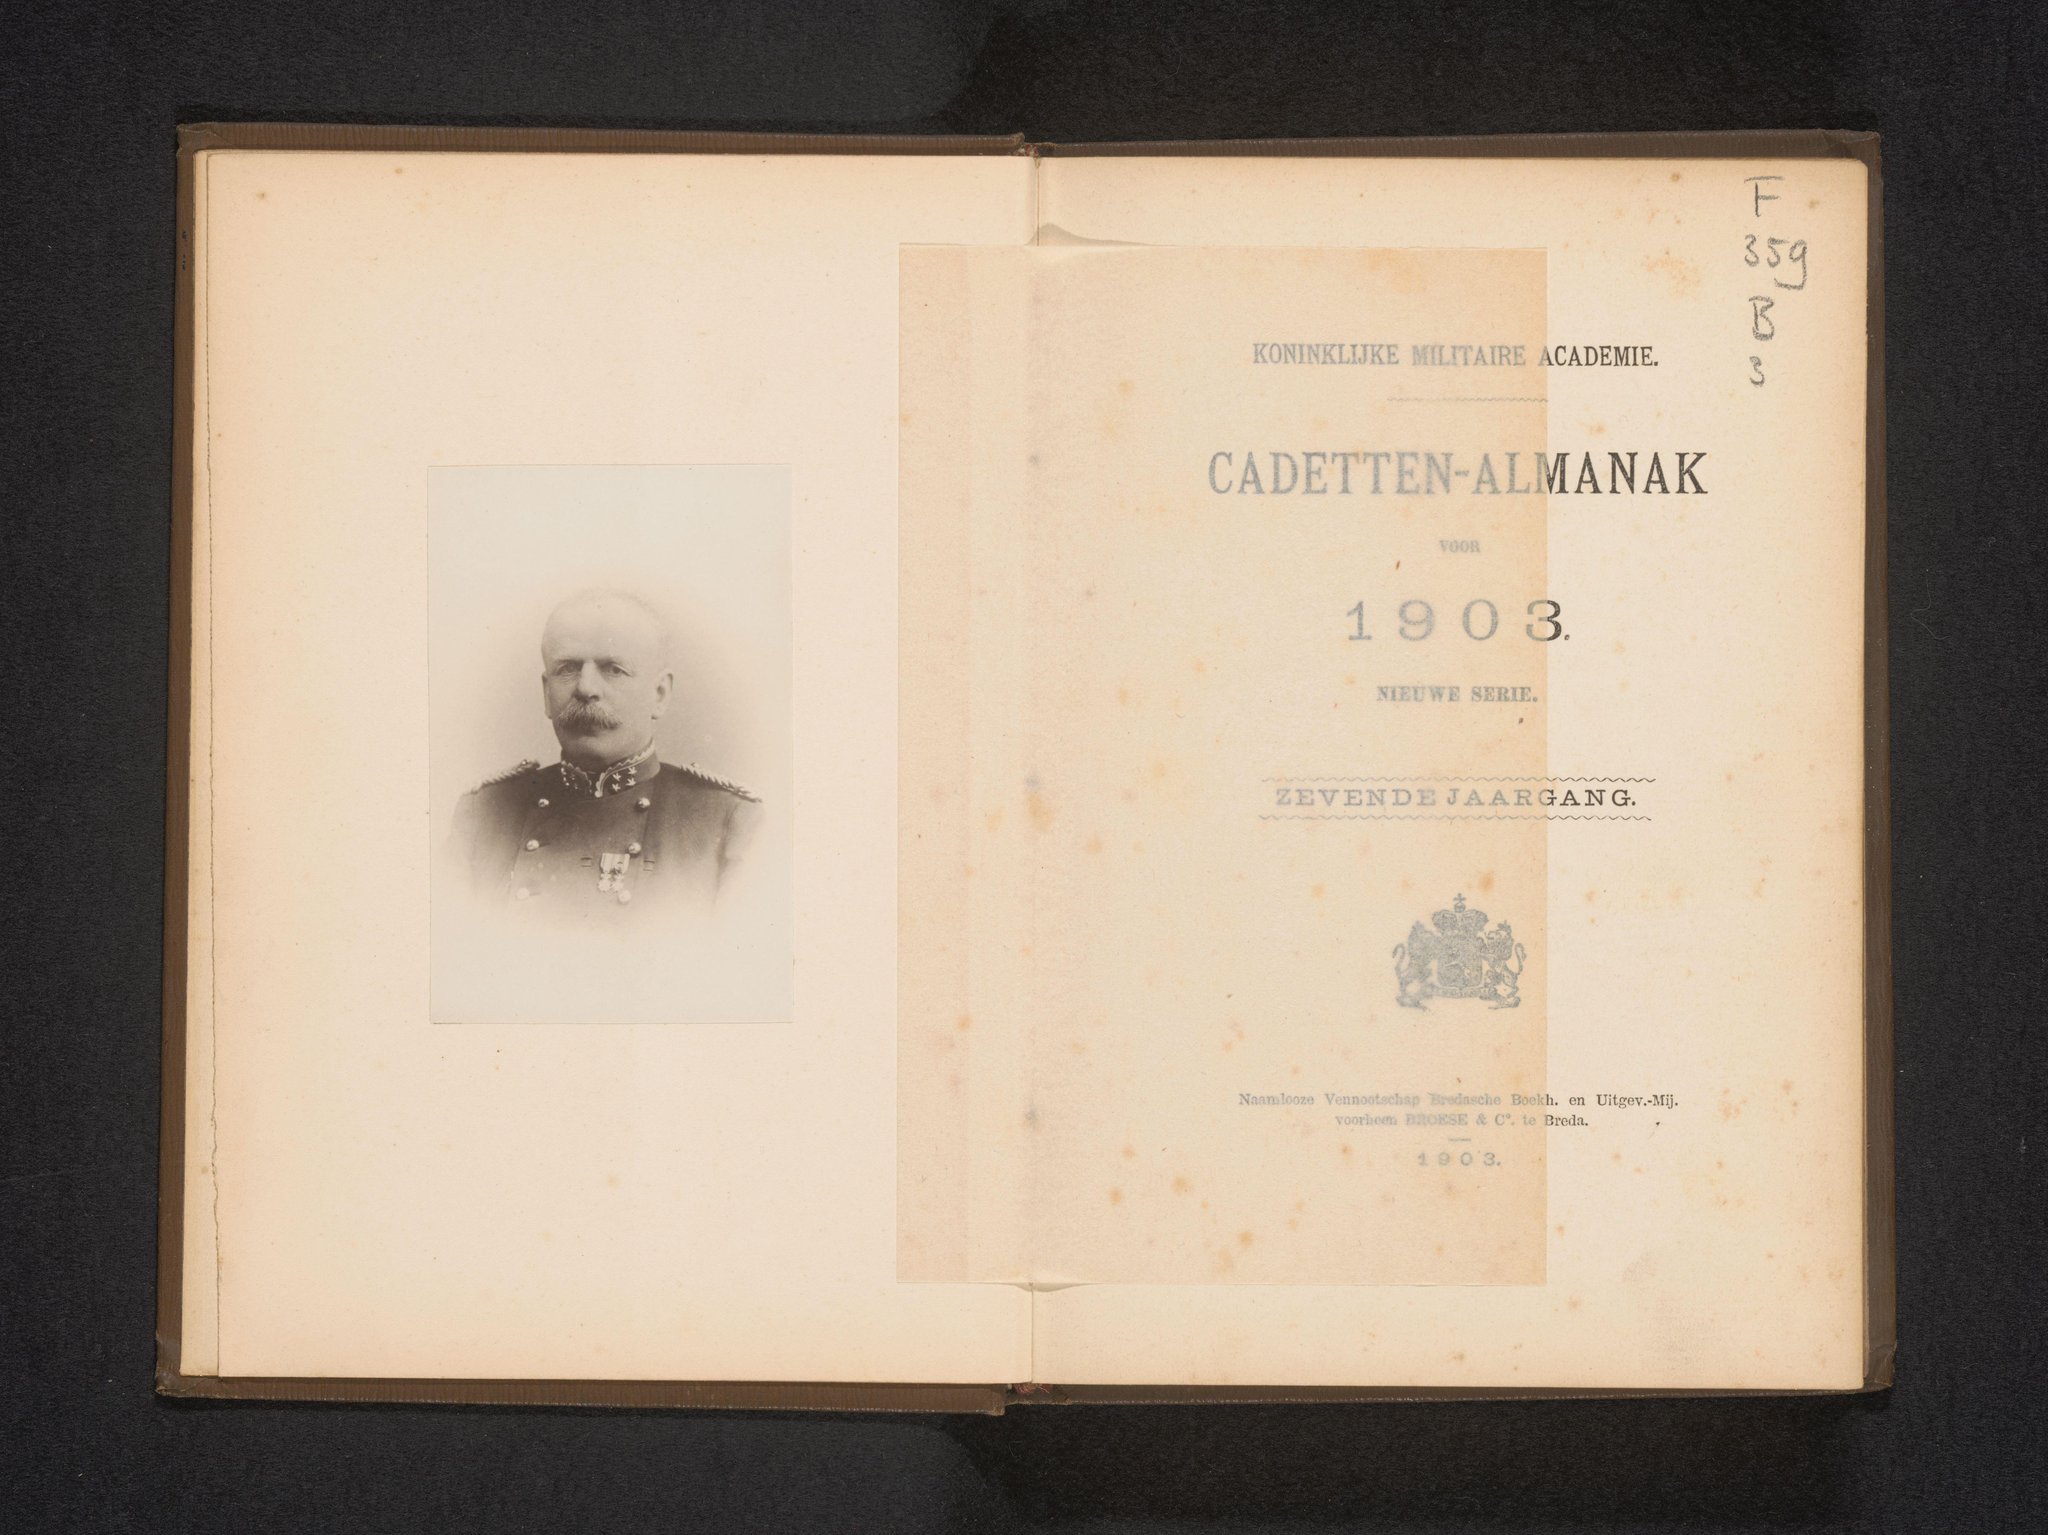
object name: page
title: Portret van Jacob Thomas Theodoor Carel van Dam van Isselt, oud-inspecteur van het militair onderwijs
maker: Anonymous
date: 1898-1903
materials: photographic support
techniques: gelatin silver print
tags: historical persons